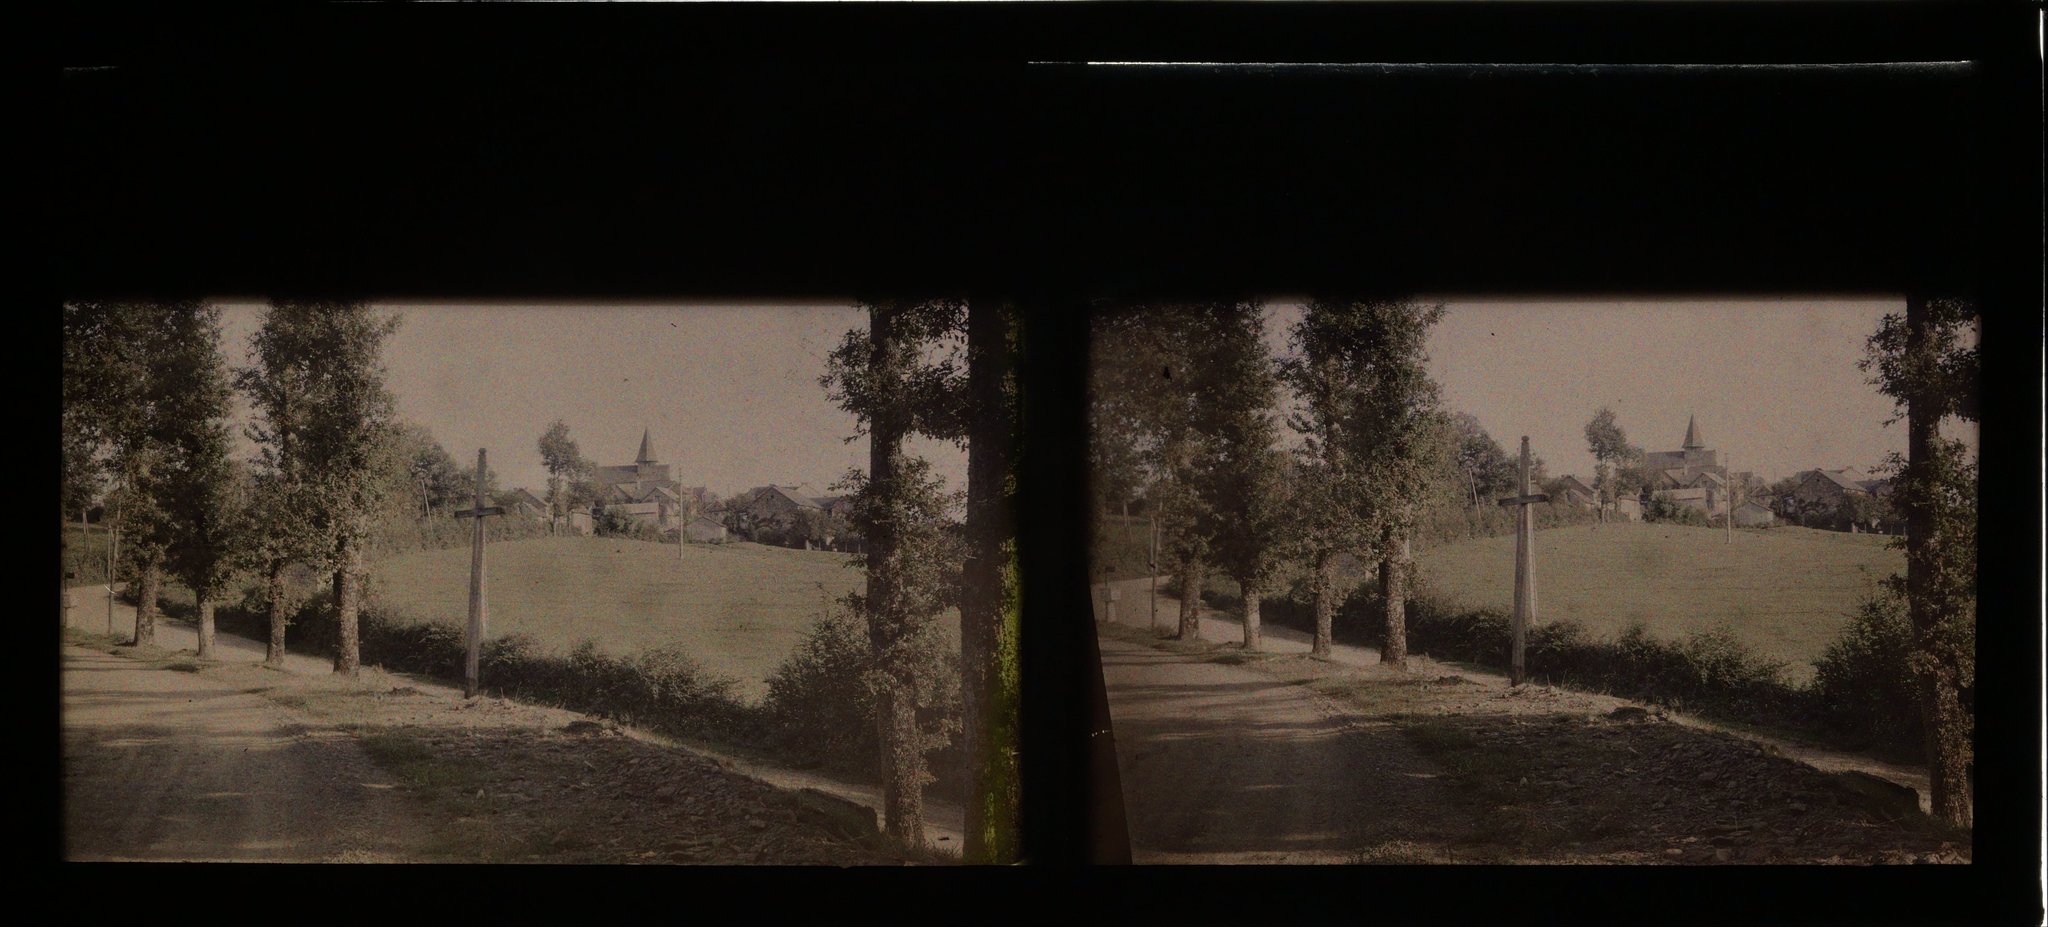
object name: stereograph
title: Weg langs rivier, met op de achtergrond een dorp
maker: Anonymous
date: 1910-1940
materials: glass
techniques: autochrome process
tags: landscapes